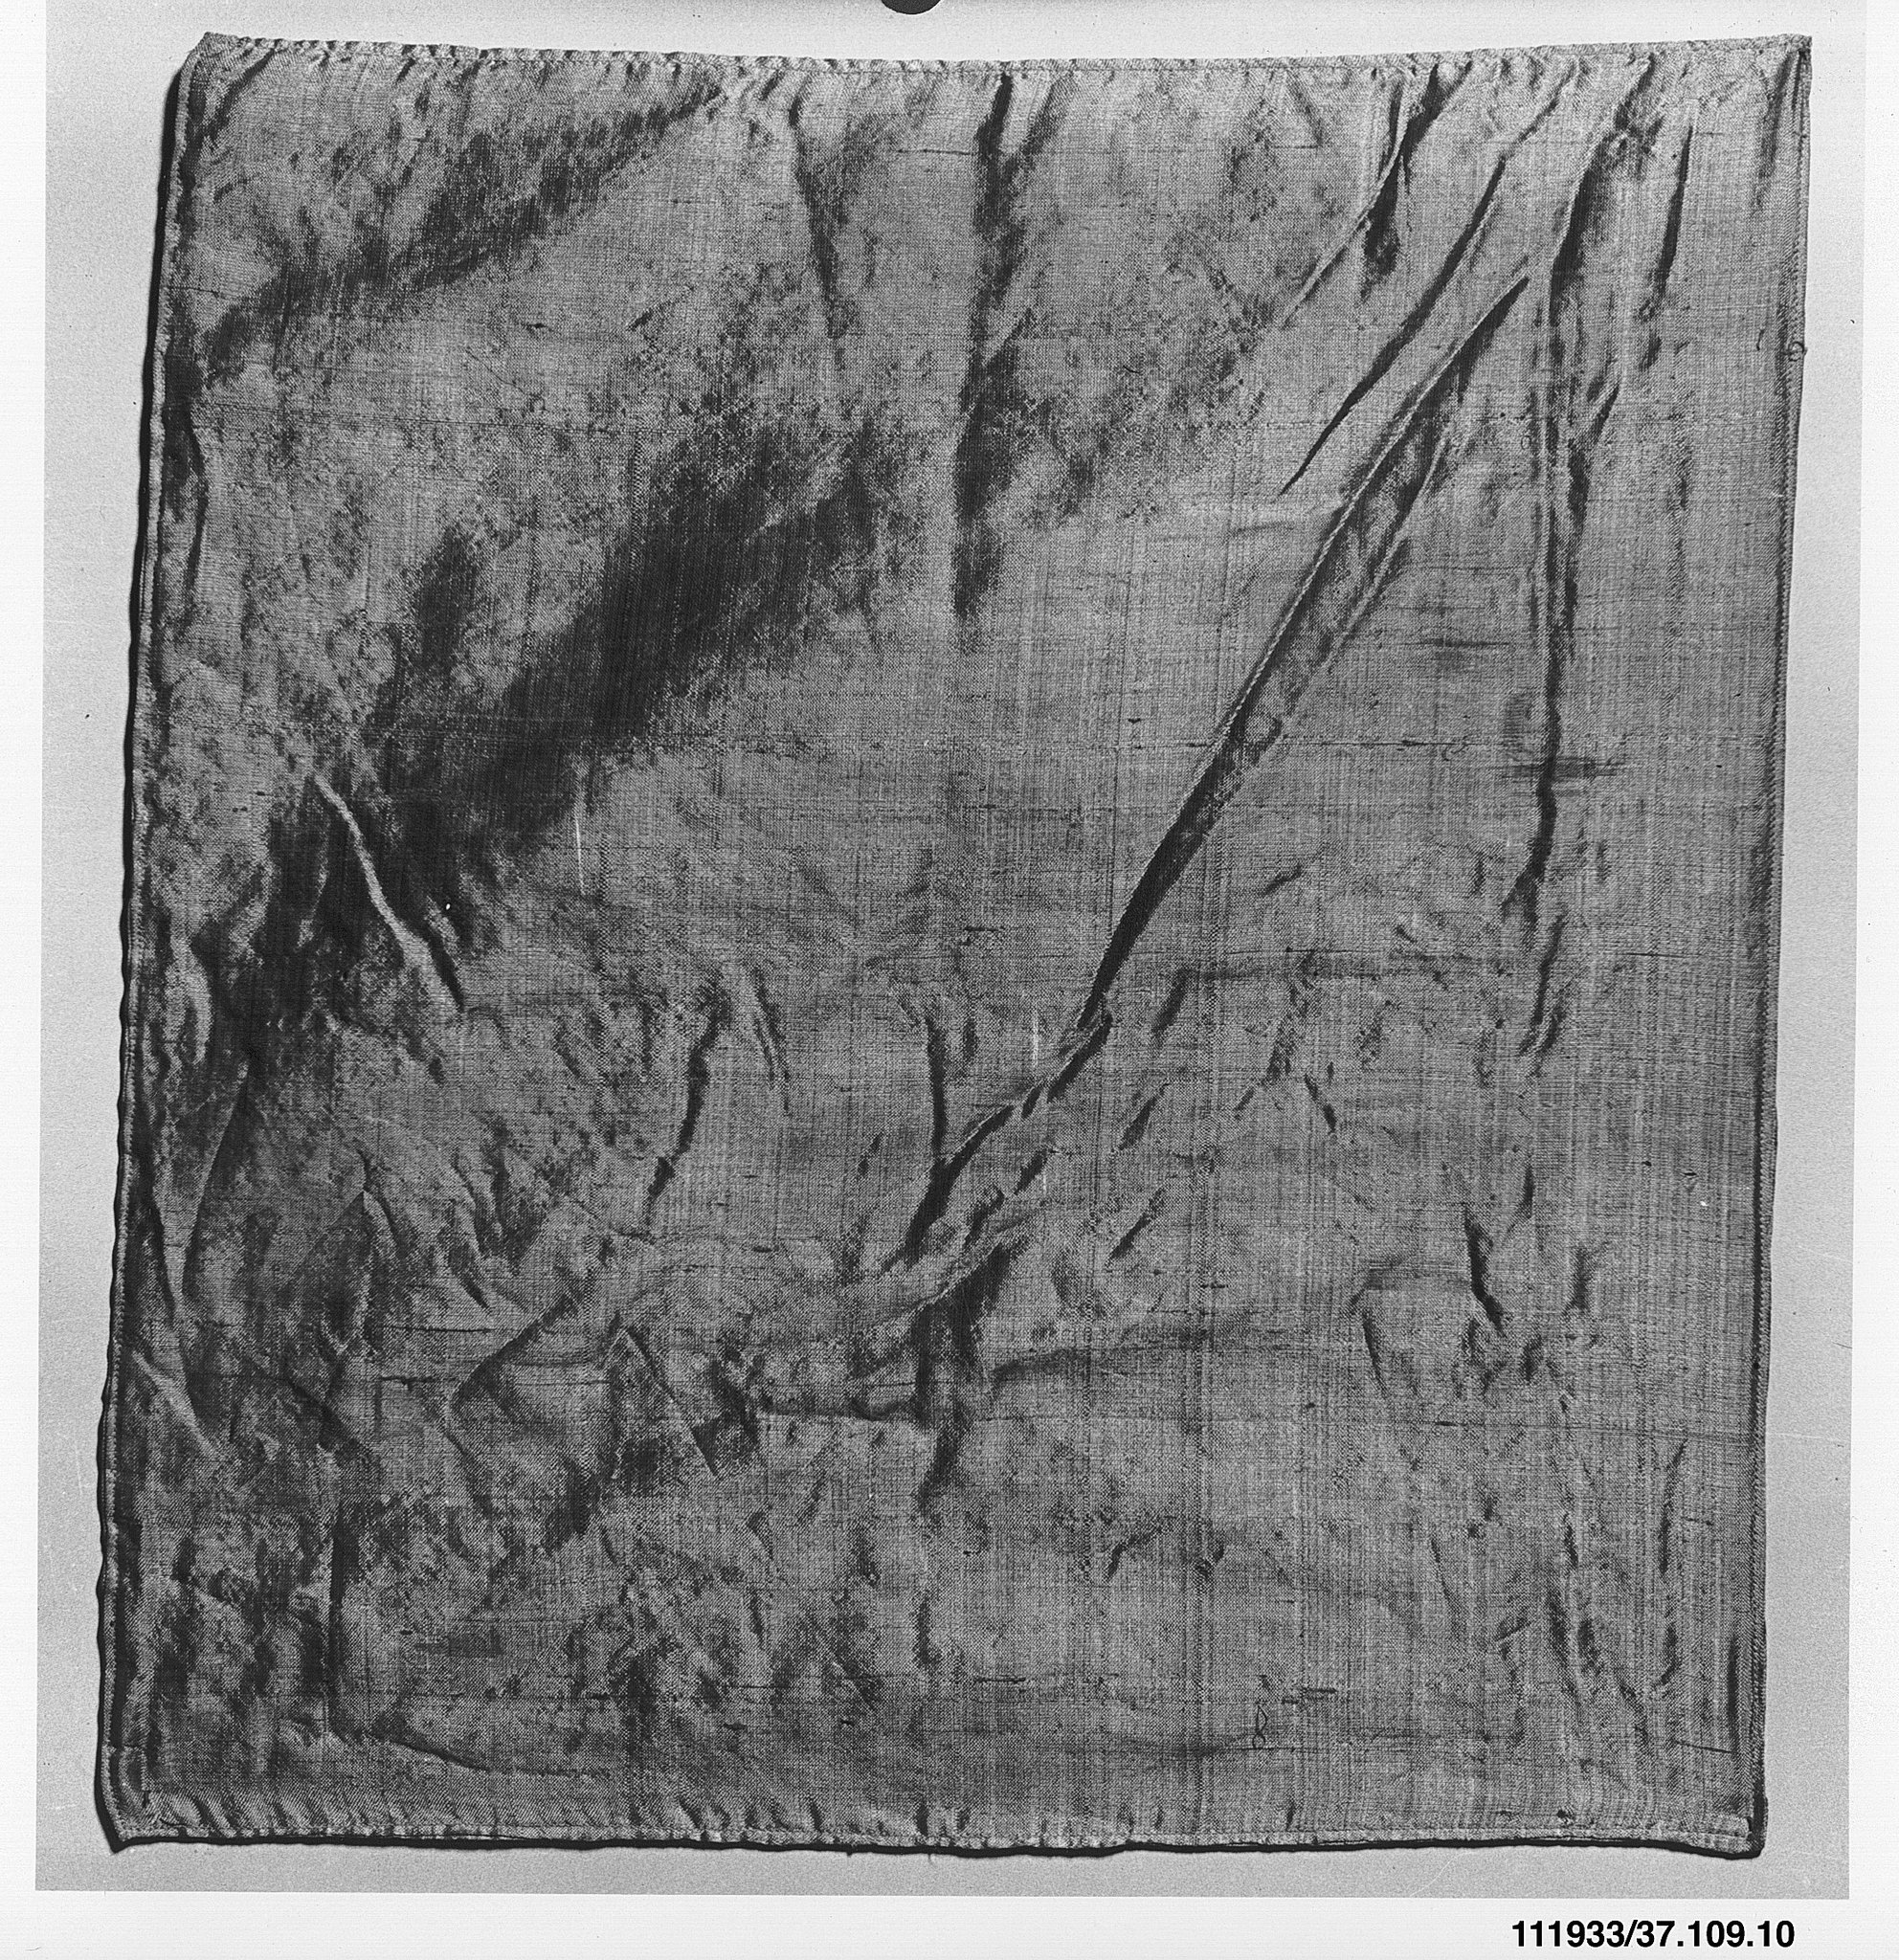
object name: piece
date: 1801-1900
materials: fiber